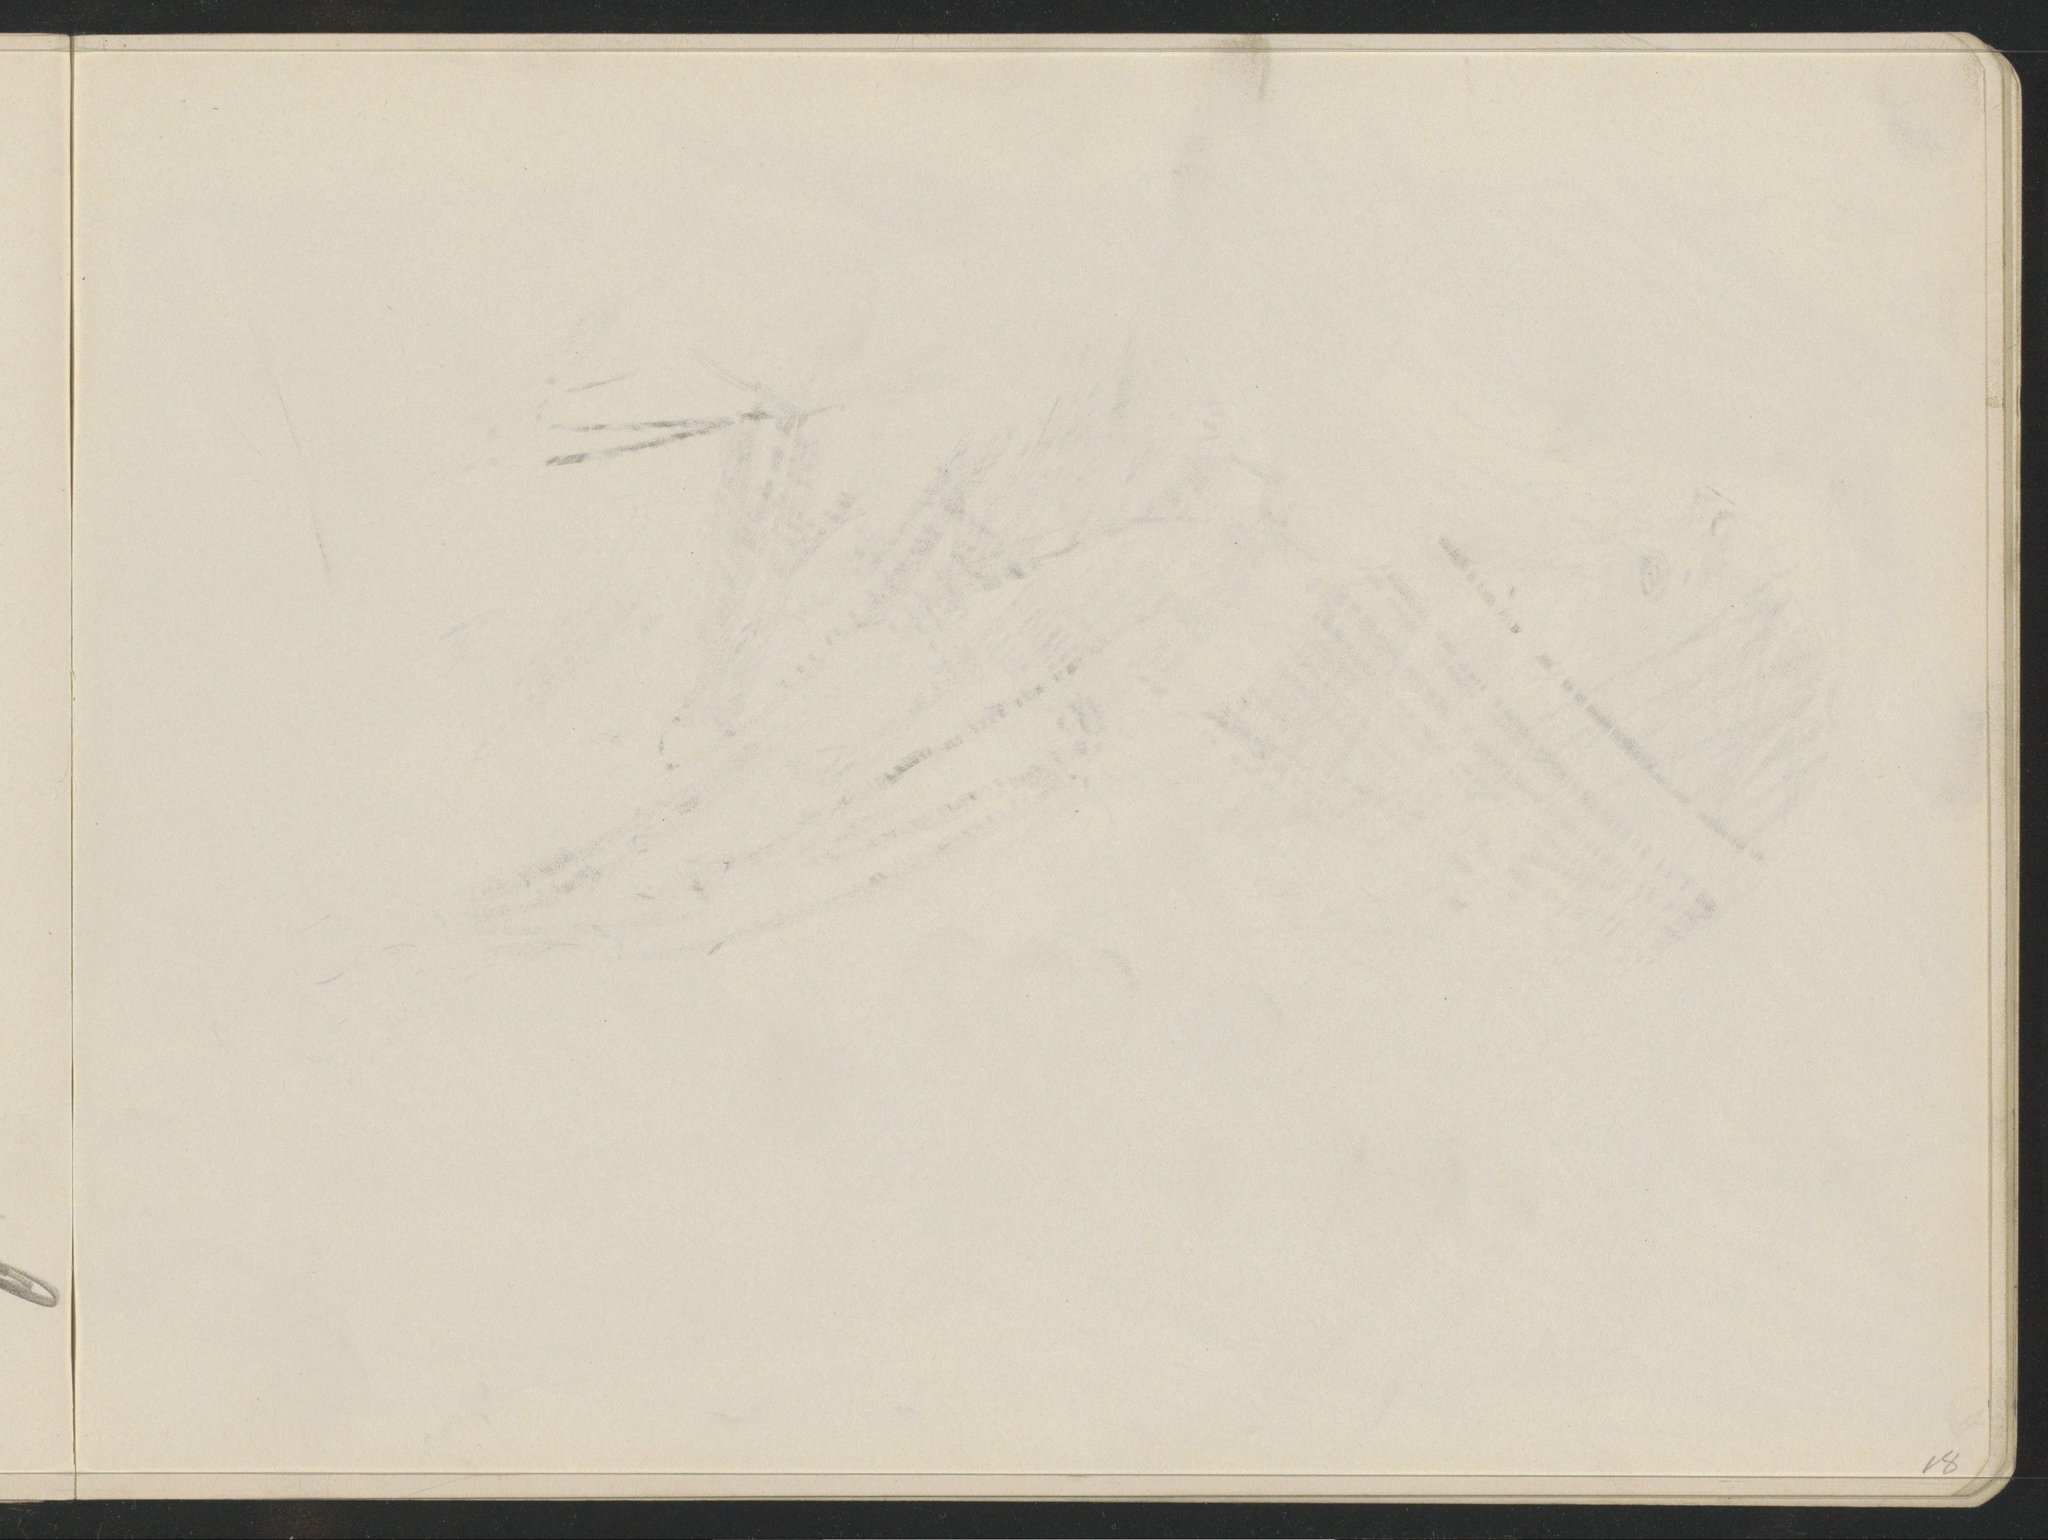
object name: sketchbook leaf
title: Abklatsch van de potloodtekening op blad 17 verso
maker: isaac israels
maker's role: draughtsman, painter, print maker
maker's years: 1865-1934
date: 1915-1934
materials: paper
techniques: printmaking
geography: the hague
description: Blad 18 recto uit schetsboek XVII met 31 bladen.